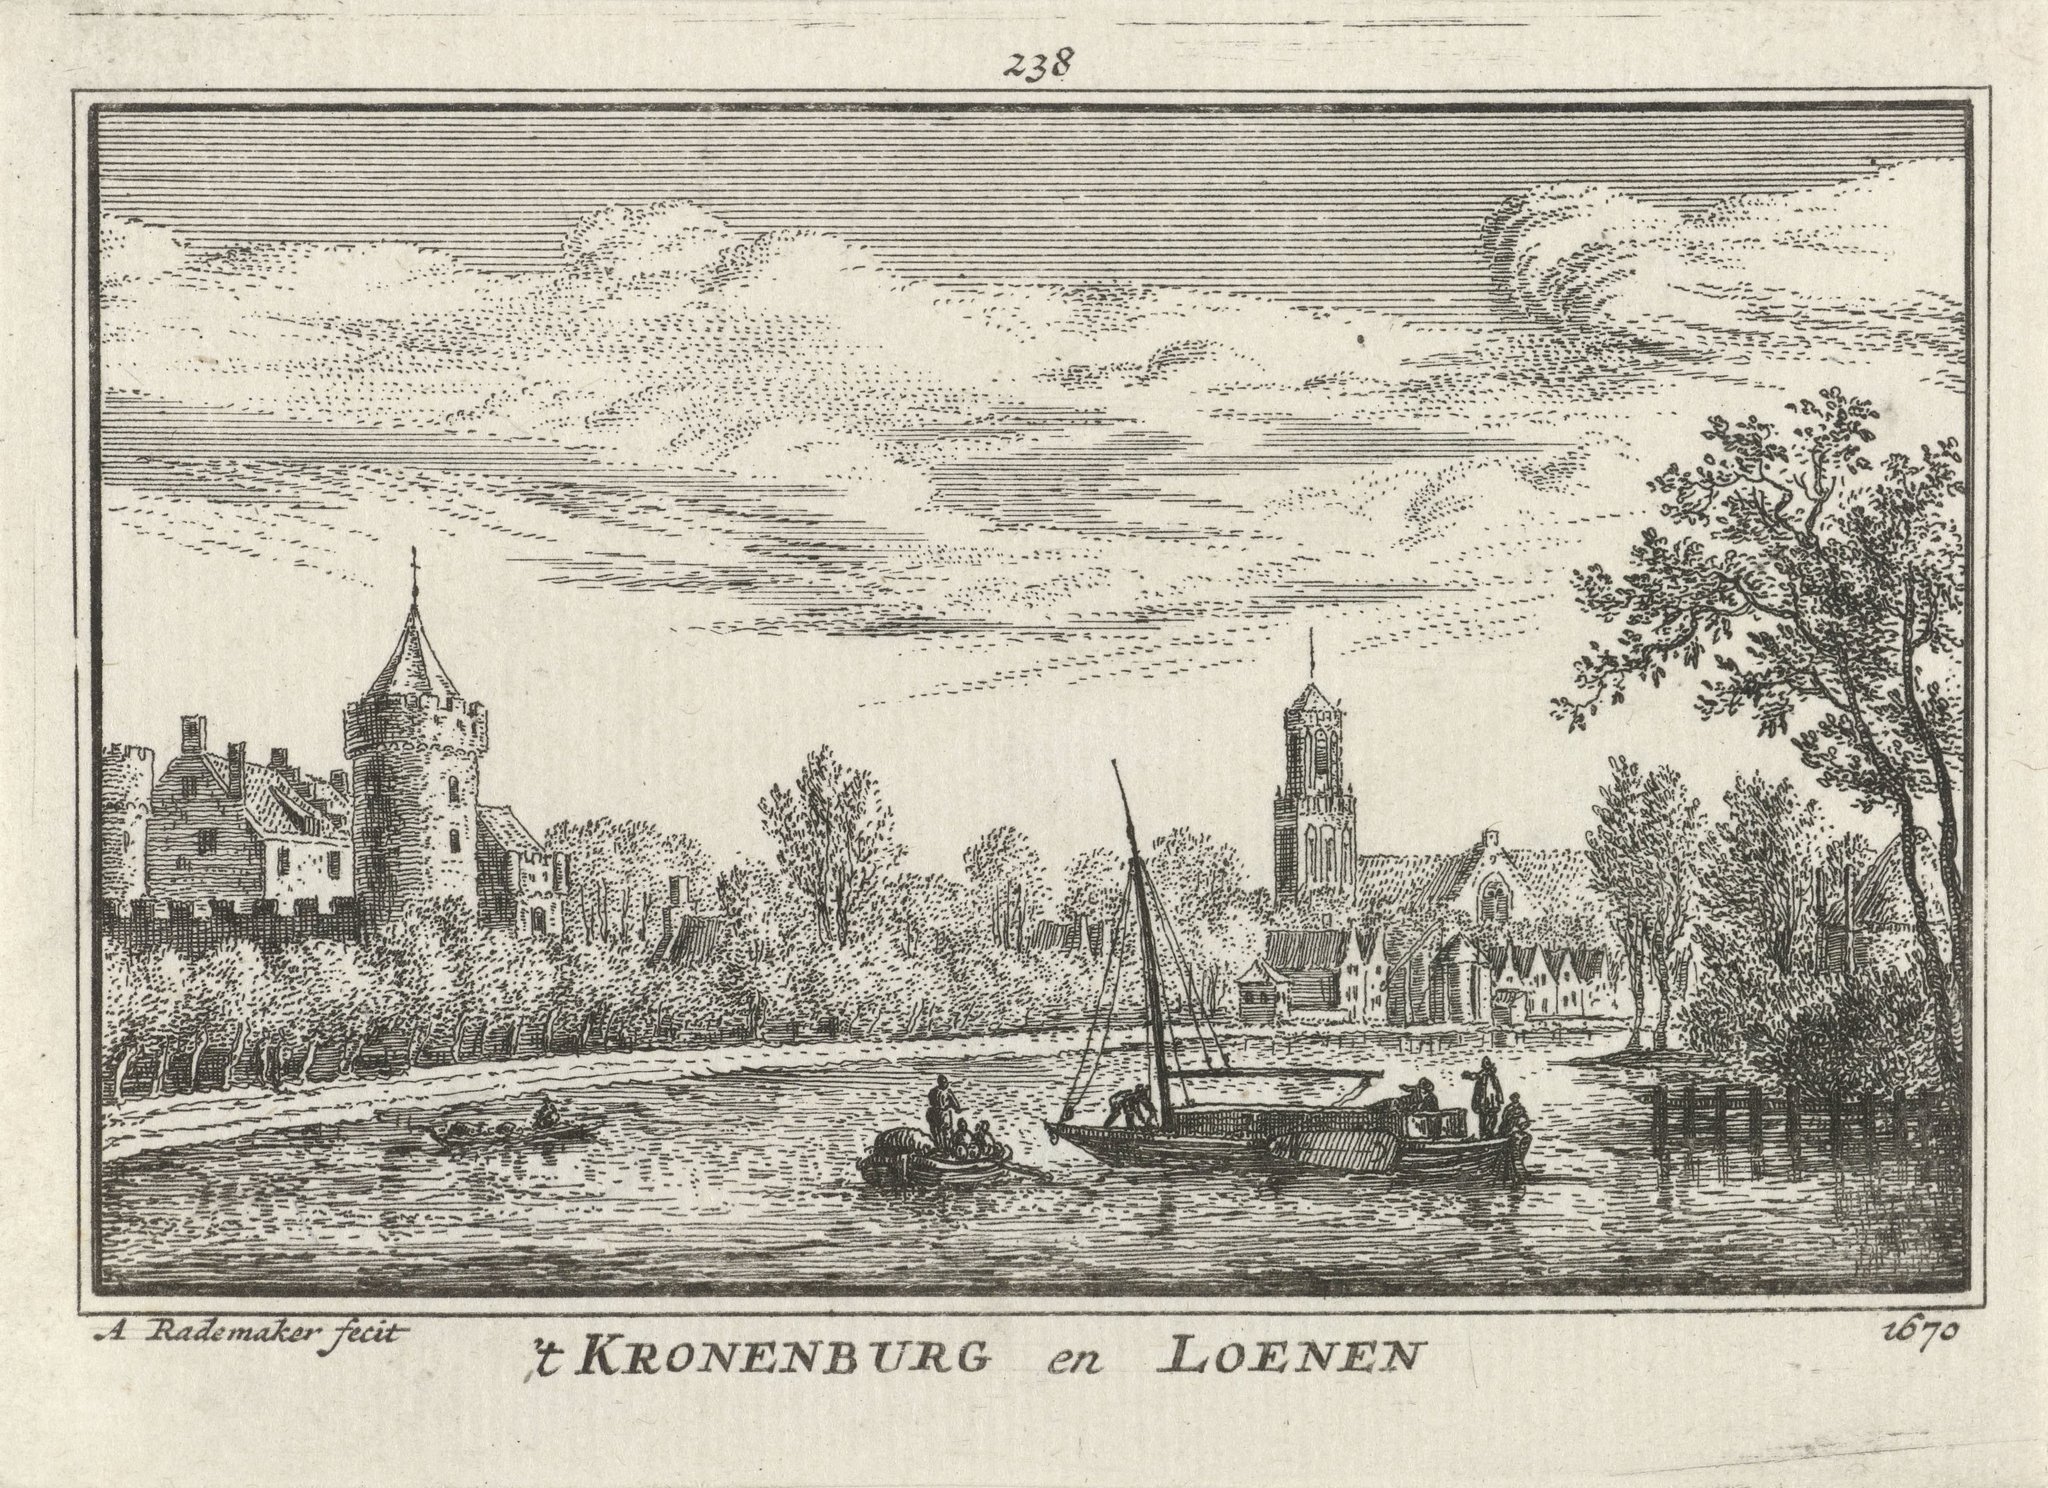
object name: print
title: Gezicht op Huis Kronenburg en Loenen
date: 1727-1733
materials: paper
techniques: etching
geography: amsterdam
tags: castle, church (exterior), rowing-boat, canoe, etc.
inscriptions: collector's mark: Lugt 2228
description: Illustratie uit: Abraham Rademaker, Matthaeus Brouërius van Niedek, Isaac Le Long, Kabinet van Nederlandsche en Kleefsche outheden en (...) voorname stads- en landgebouwen, Willem Barents en Antoni Schoonenburg: Amsterdam, 1727-1733, ill. nr. 238.